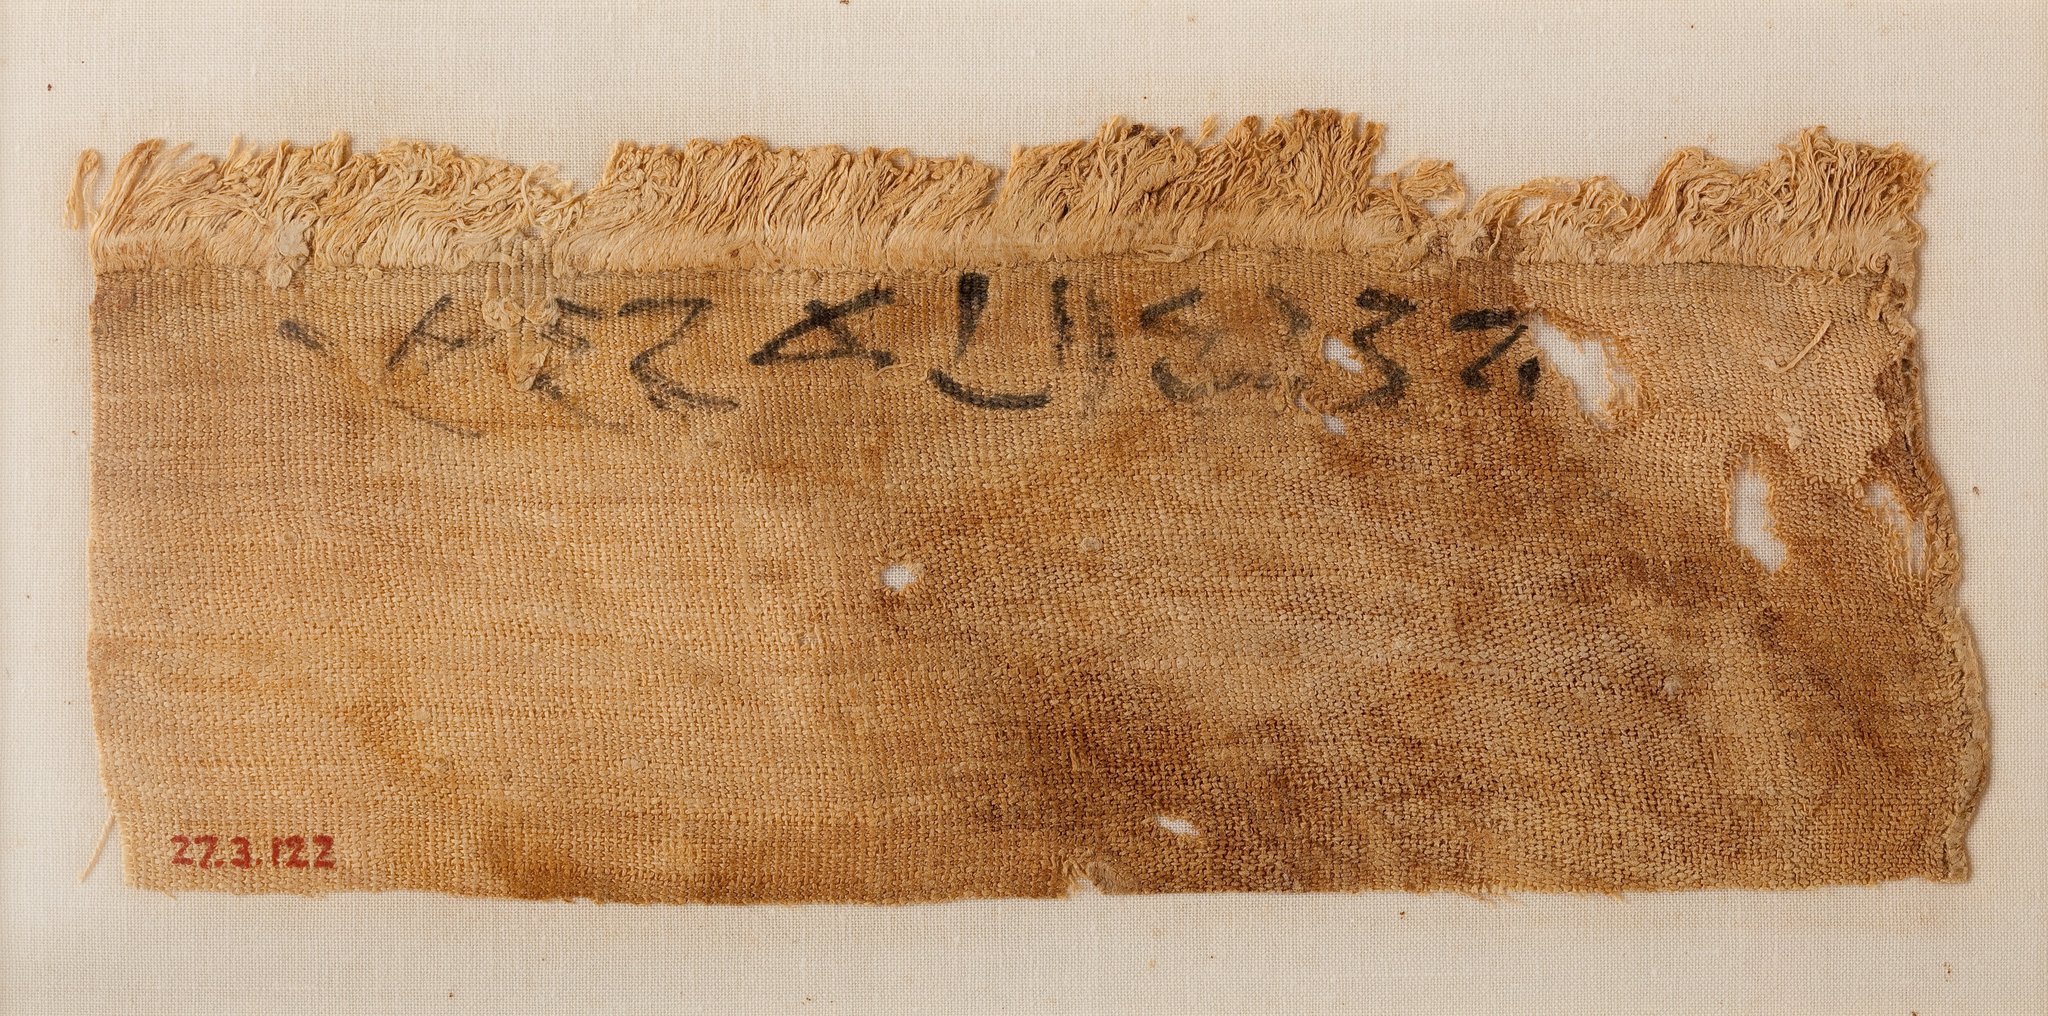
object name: linen mark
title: Linen mark (Type XXIV)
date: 1961-1917 BCE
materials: linen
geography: egypt